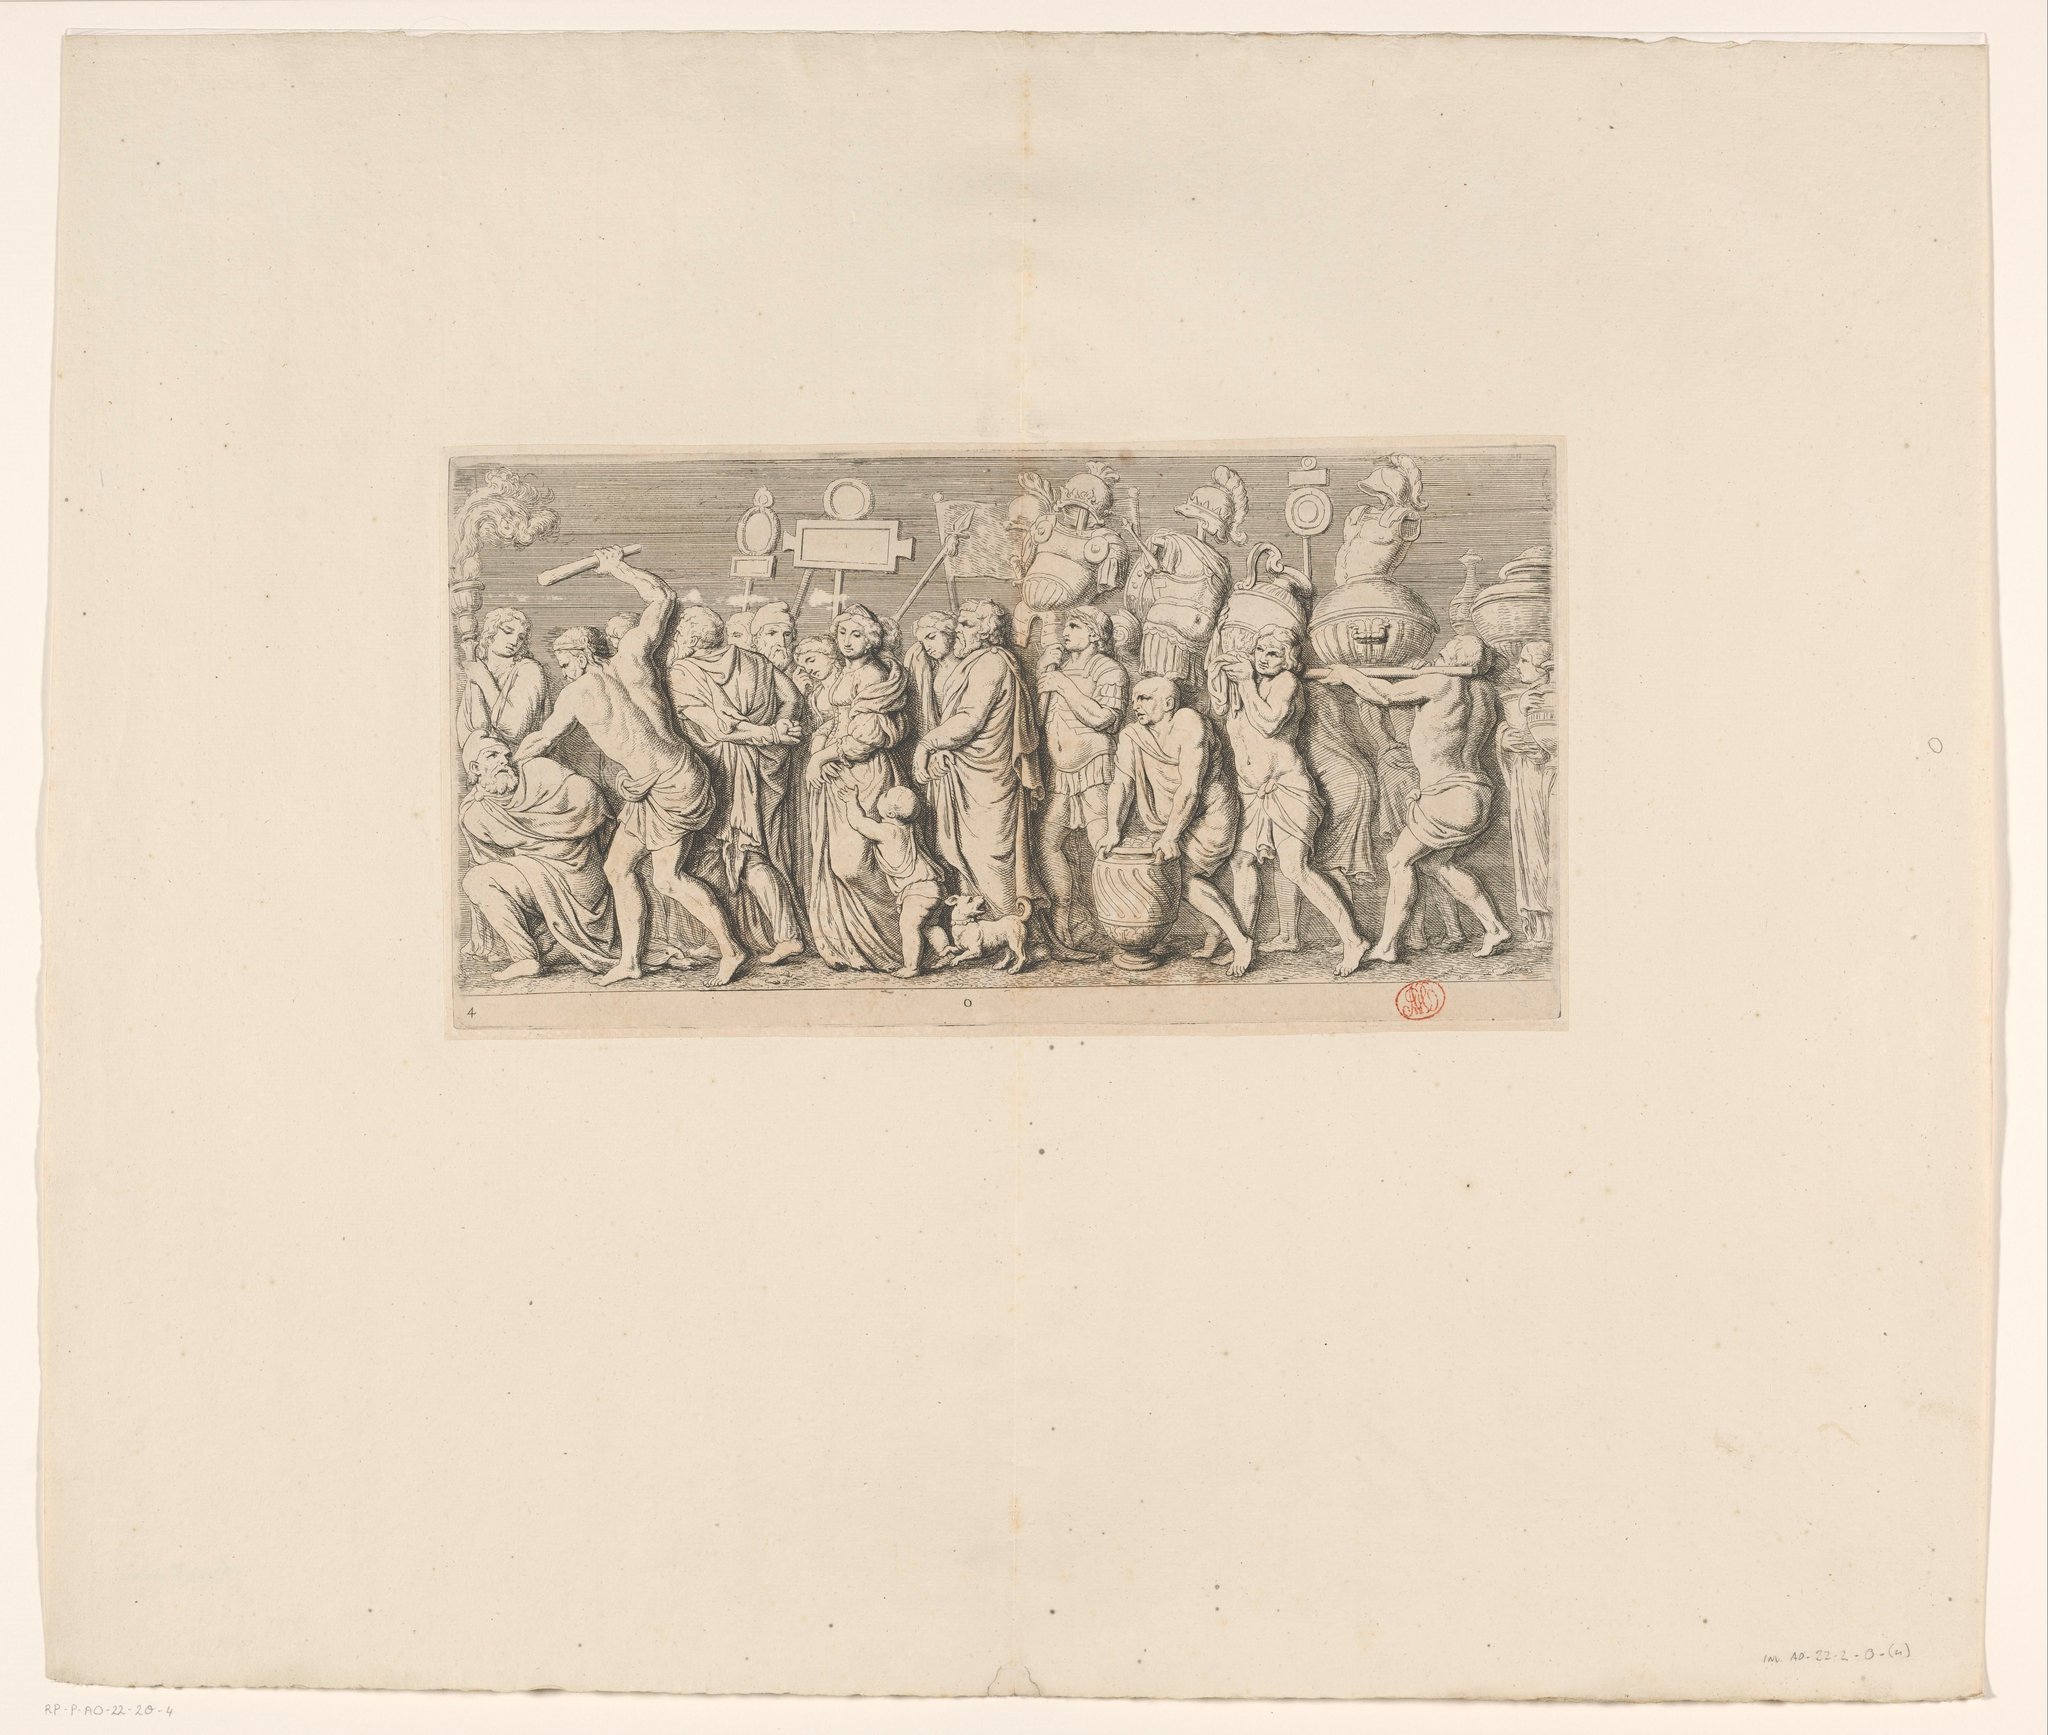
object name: book illustration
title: Fries met triomftocht van Quintus Fabius Maximus op schouw in Burgemeesterskamer van het Stadhuis op de Dam (vierde deel)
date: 1663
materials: paper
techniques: engraving, etching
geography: amsterdam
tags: triumphal entry and public reception, pageant, 'entrée solennelle', 'joyeuse entrée', trophy ~ battle, war, triumphs (allegorical and symbolic), conqueror triumphing, triumphal entry of victor, prisoner of war (after the battle), (military) flags and standards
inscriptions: collector's mark: Lugt 195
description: Aangezien er meerdere (in ieder geval vier) Quinti Fabii Maximi zijn geweest die consul waren en één of meerdere triomftochten hebben gekregen, is niet met zekerheid te zeggen om welke triomftocht en welke Quintus Fabius Maximus het gaat. Maar het is waarschijnlijk dat het gaat om Quintus Fabius Maximus Verrucosus Cunctator (ca. 275 v.Chr. - 203 v.Chr.), die is afgebeeld op het schilderij van Jan Lievens dat boven de schouw hangt. Op dit schilderij is te zien hoe hij, in 213 v.Chr., op bevel van zijn naamgenoot en zoon Quintus Fabius Maximus - die in dat jaar consul was - van zijn paard afstijgt. Zijn zoon is maar eenmaal consul geweest en heeft geen triomfen behaald. Prent gebruikt in: Secunca pars Praecipuarum effigierum ac ornamentorum amplissime Curiae Amstelrodamensis maiori ex parte in cadido marmore effectorum per Artum Quellinium eiusdem Civitatis Statuarium / Het tweede deel Van de voornaemste Statuen ende Cieraten van 't konst-rijcke Stadt-huys van Amstelredam 'tmeeste in Marmer gemaeckt door Artus Quellinus Beelthouwer der voorseyde Stadt. Amsterdam: Artus Quellinus (I), 1663. Zie RP-P-AO-22-2-1 voor bijhorende titelpagina. Zie RP-P-AO-22-2-2 voor bijhorend register. Zie RP-P-AO-22-2A, RP-P-AO-22-2B, RP-P-AO-22-2C-1, RP-P-AO-22-2C-2, RP-P-AO-22-2C-3, RP-P-AO-22-2C-4, RP-P-AO-22-2D-1, RP-P-AO-22-2D-2, RP-P-AO-22-2D-3, RP-P-AO-22-2E-1, RP-P-AO-22-2E-2, RP-P-AO-22-2E-3, RP-P-AO-22-2E-4, RP-P-AO-22-2F-1, RP-P-AO-22-2F-2, RP-P-AO-22-2F-3, RP-P-AO-22-2G, RP-P-AO-22-2H, RP-P-AO-22-2I, RP-P-AO-22-2K, RP-P-AO-22-2L, RP-P-AO-22-2M, RP-P-AO-22-2N, RP-P-AO-22-2O-1, RP-P-AO-22-2O-2, RP-P-AO-22-2O-3, RP-P-AO-22-2O-5, RP-P-AO-22-2O-6, RP-P-AO-22-2O-7, RP-P-AO-22-2P-1, RP-P-AO-22-2P-2, RP-P-AO-22-2Q-1, RP-P-AO-22-2Q-2, RP-P-AO-22-2Q-3, RP-P-AO-22-2R-1, RP-P-AO-22-2R-2, RP-P-AO-22-2R-3, RP-P-AO-22-2S, RP-P-AO-22-2T-1, RP-P-AO-22-2T-2, RP-P-AO-22-2T-3, RP-P-AO-22-2T-4, RP-P-AO-22-2V-1, RP-P-AO-22-2V-2, RP-P-AO-22-2W-1, RP-P-AO-22-2W-2, RP-P-AO-22-2X-1, RP-P-AO-22-2X-2 en RP-P-AO-22-2X-3 voor andere prenten uit deze publicatie. Zelfde staat van prent ook gebruikt in: Secunca pars Praecipuarum effigierum ac ornamentorum amplissime Curiae Amstelrodamensis maiori ex parte in cadido marmore effectorum per Artum Quellinium eiusdem Civitatis Statuarium / Het tweede deel Van de voornaemste Statuen ende Cieraten van 't konst-rijcke Stadt-huys van Amstelredam 'tmeeste in Marmer gemaeckt door Artus Quellinus Beelthouwer der voorseyde Stadt. Amsterdam: Frederik de Wit, 1668. Latere staat van prent ook gebruikt in: Architecture peinture et sculpture de la Maison de Ville d'Amsterdam, representee en CIX. figures en taille-douce (…). Amsterdam: David Mortier, 1719. En in: Architecture peinture et sculpture de la Maison de Ville d'Amsterdam, representee en CIX. figures en taille-douce (…). Amsterdam: Gerard Valck, 1719. En in: Bouw schilder en beeldhouwkonst, van het Stadhuis te Amsteldam, vertoont in CIX figuuren (…). Amsterdam: Covens & Mortier & Covens Jr., s.a. (1774-1783).